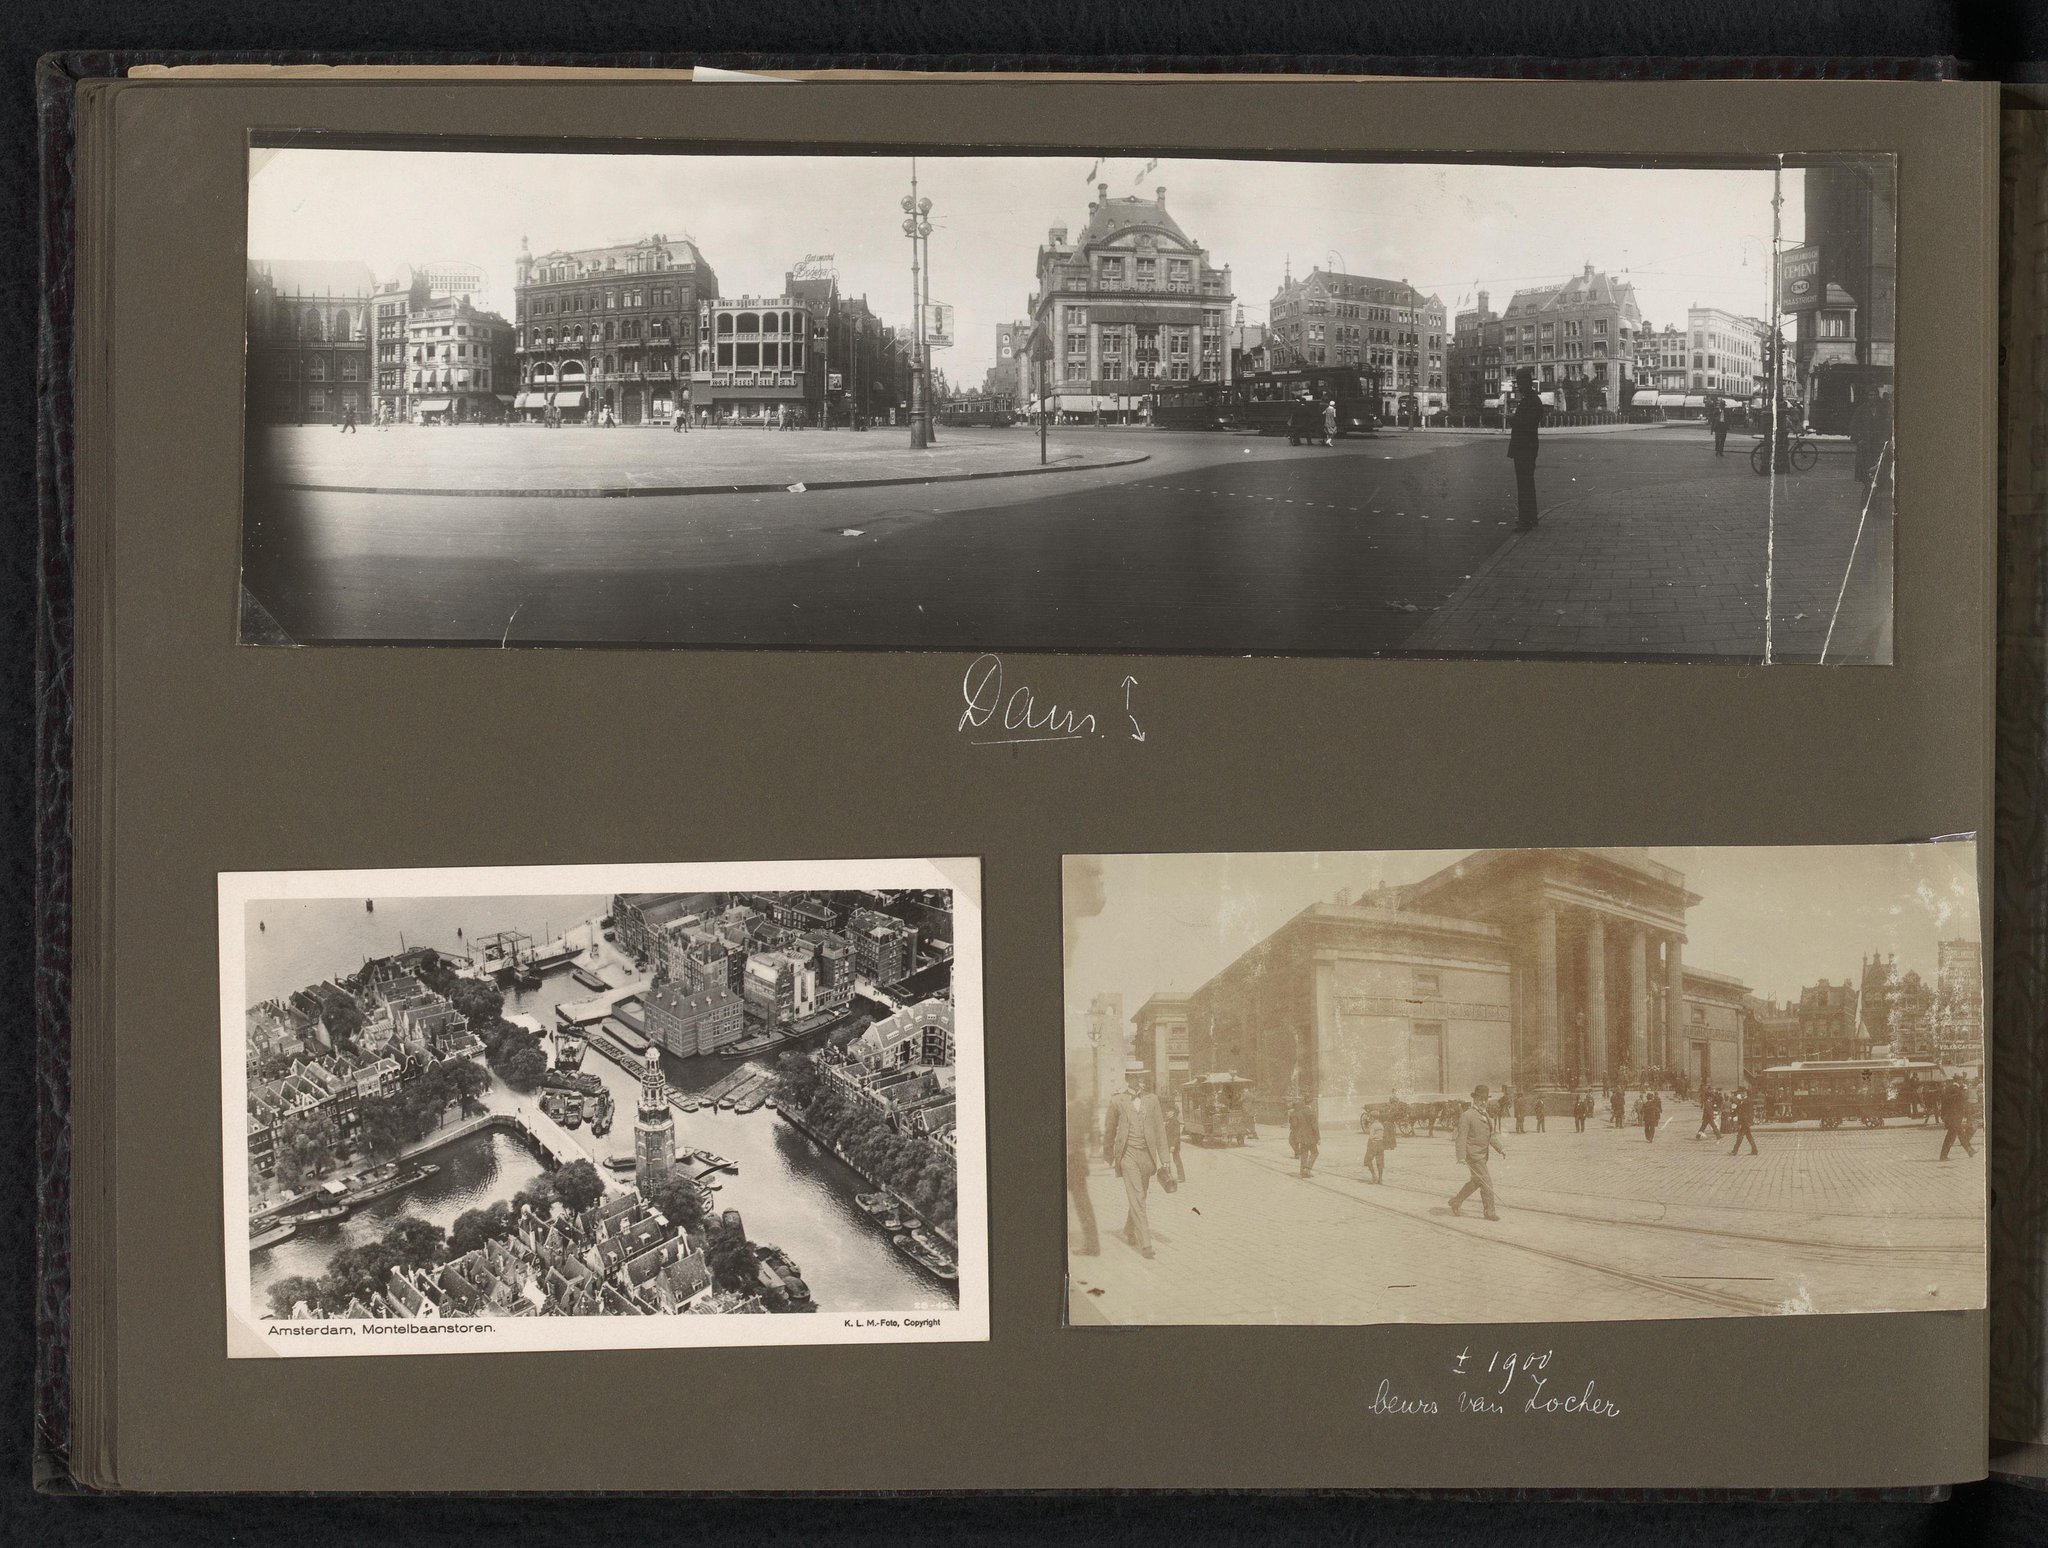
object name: aerial photograph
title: Drie foto's van de Dam en de Montelbaanstoren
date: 1890-1931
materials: paper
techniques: albumen print, gelatin silver print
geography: netherlands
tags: square, place, circus, etc., tower, clock tower ~ monumental adornment, canals, waters (in city)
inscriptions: inscription: ‘± 1900/ beurs van Zocher’, inscription: ‘Amsterdam, Montelbaanstoren’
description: Deze foto's maken deel uit van een album.